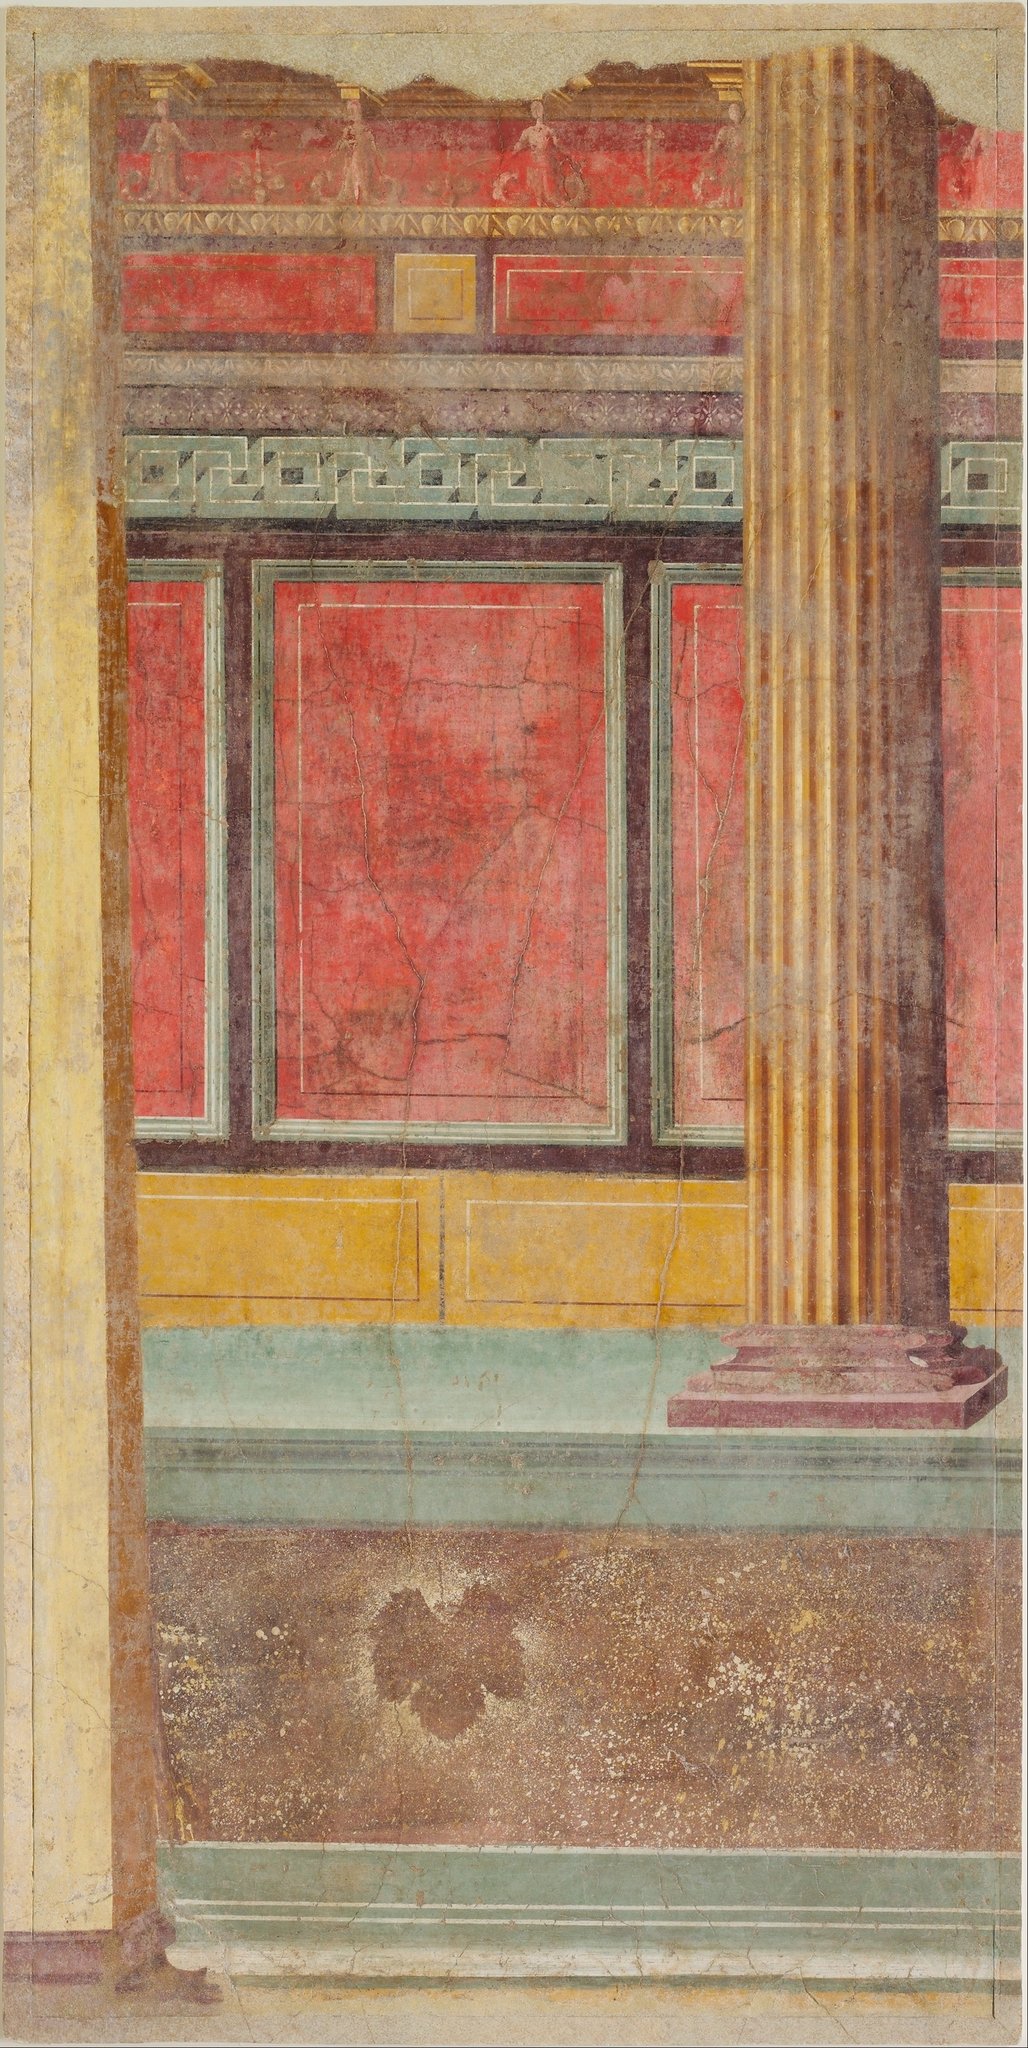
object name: wall painting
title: Wall painting from Room F of the Villa of P. Fannius Synistor at Boscoreale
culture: roman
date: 50-40 BCE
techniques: fresco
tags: columns